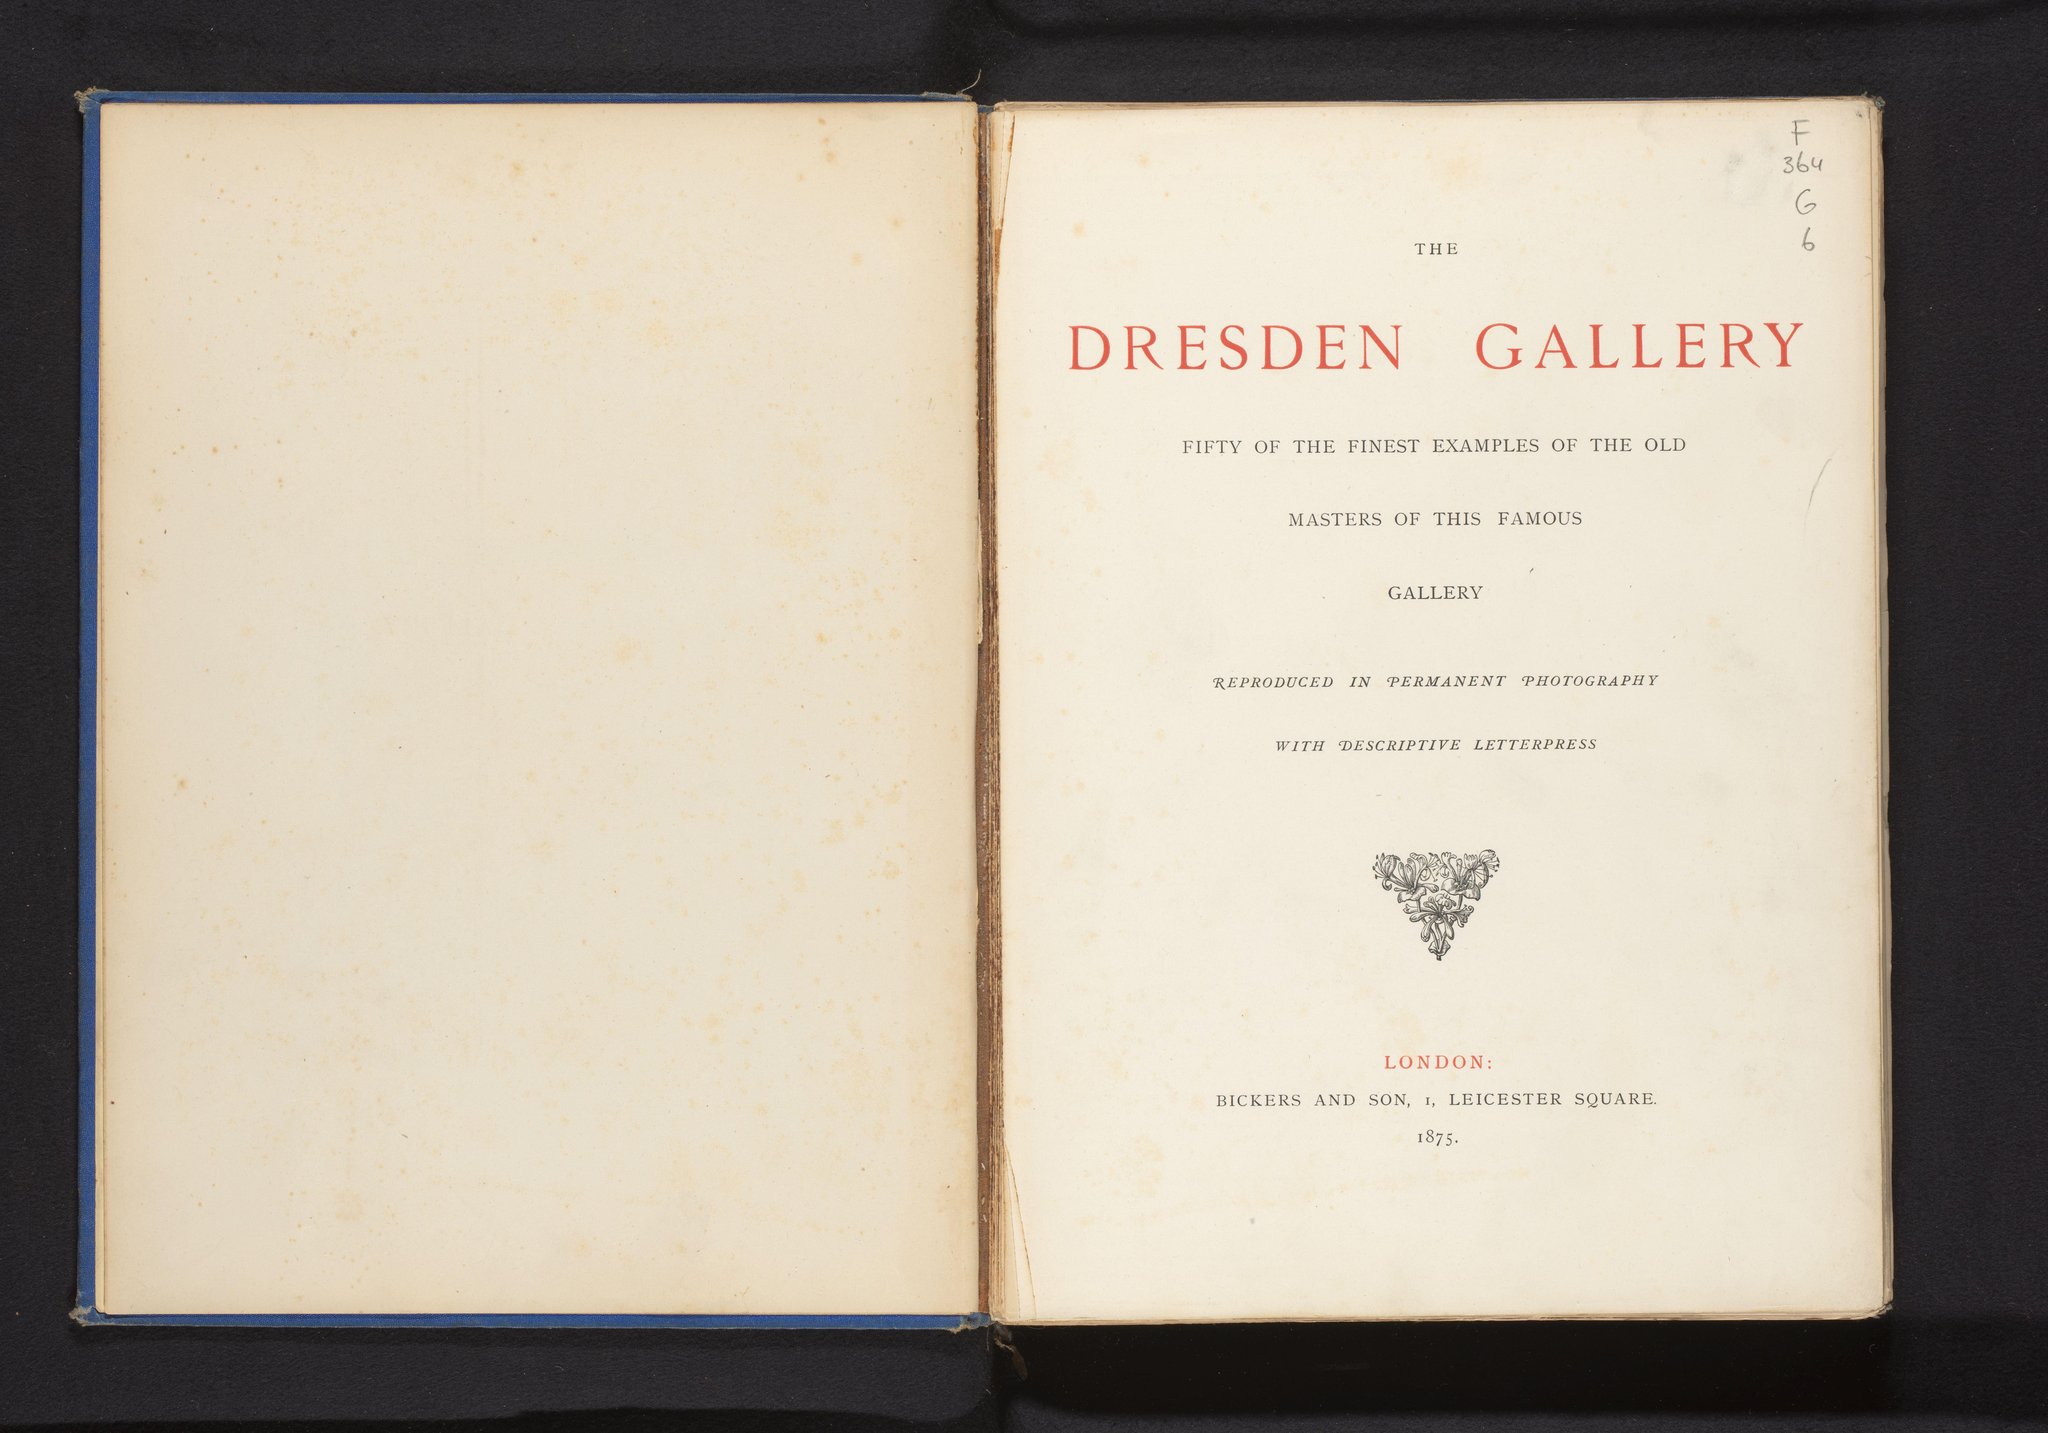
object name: book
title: The Dresden Gallery : fifty of the finest examples of the old masters of this famous gallery reproduced in permanent photography with descriptive letterpress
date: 1875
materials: cardboard, leather, linen, paper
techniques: printing, woodburytype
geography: london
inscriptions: date: ‘SEPT 1998’, annotation: ‘[...]’